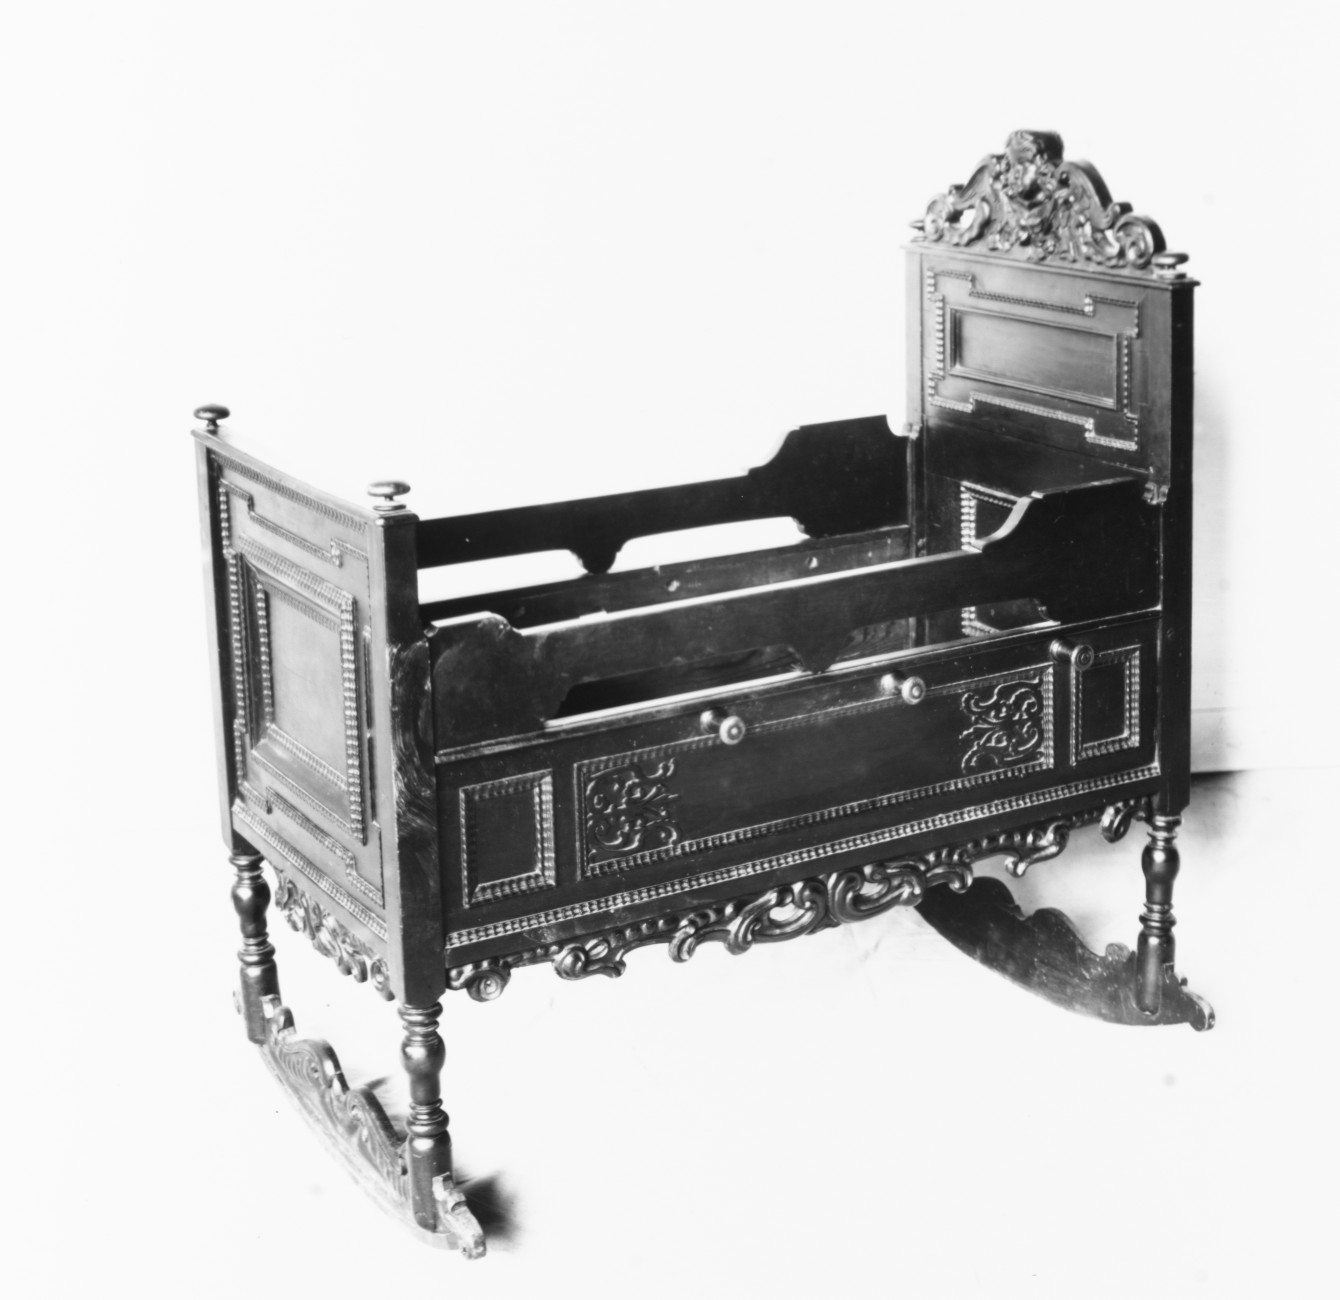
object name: cradle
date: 1650-1680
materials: wood